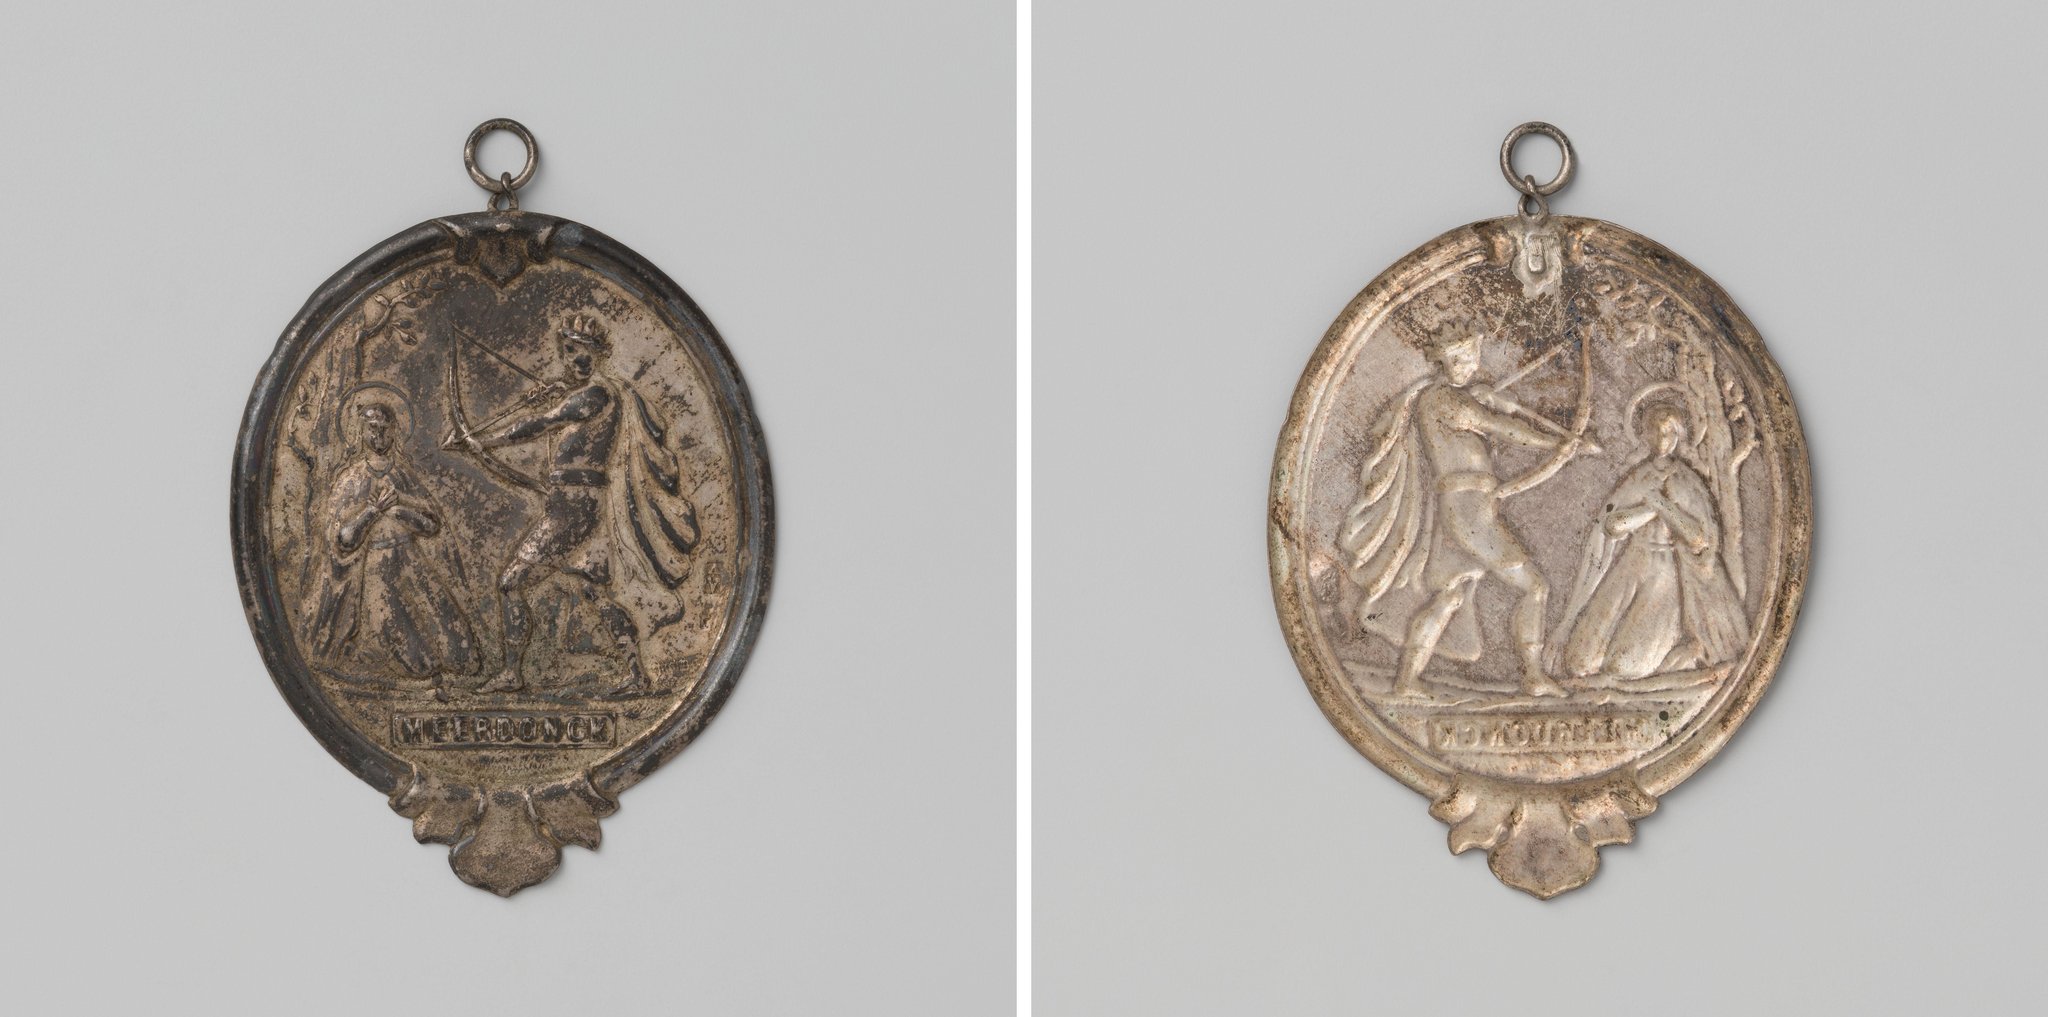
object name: marksman medal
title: Meerdonck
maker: Anonymous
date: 1800-1875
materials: silver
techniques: casting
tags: jezus christus, meerdonck